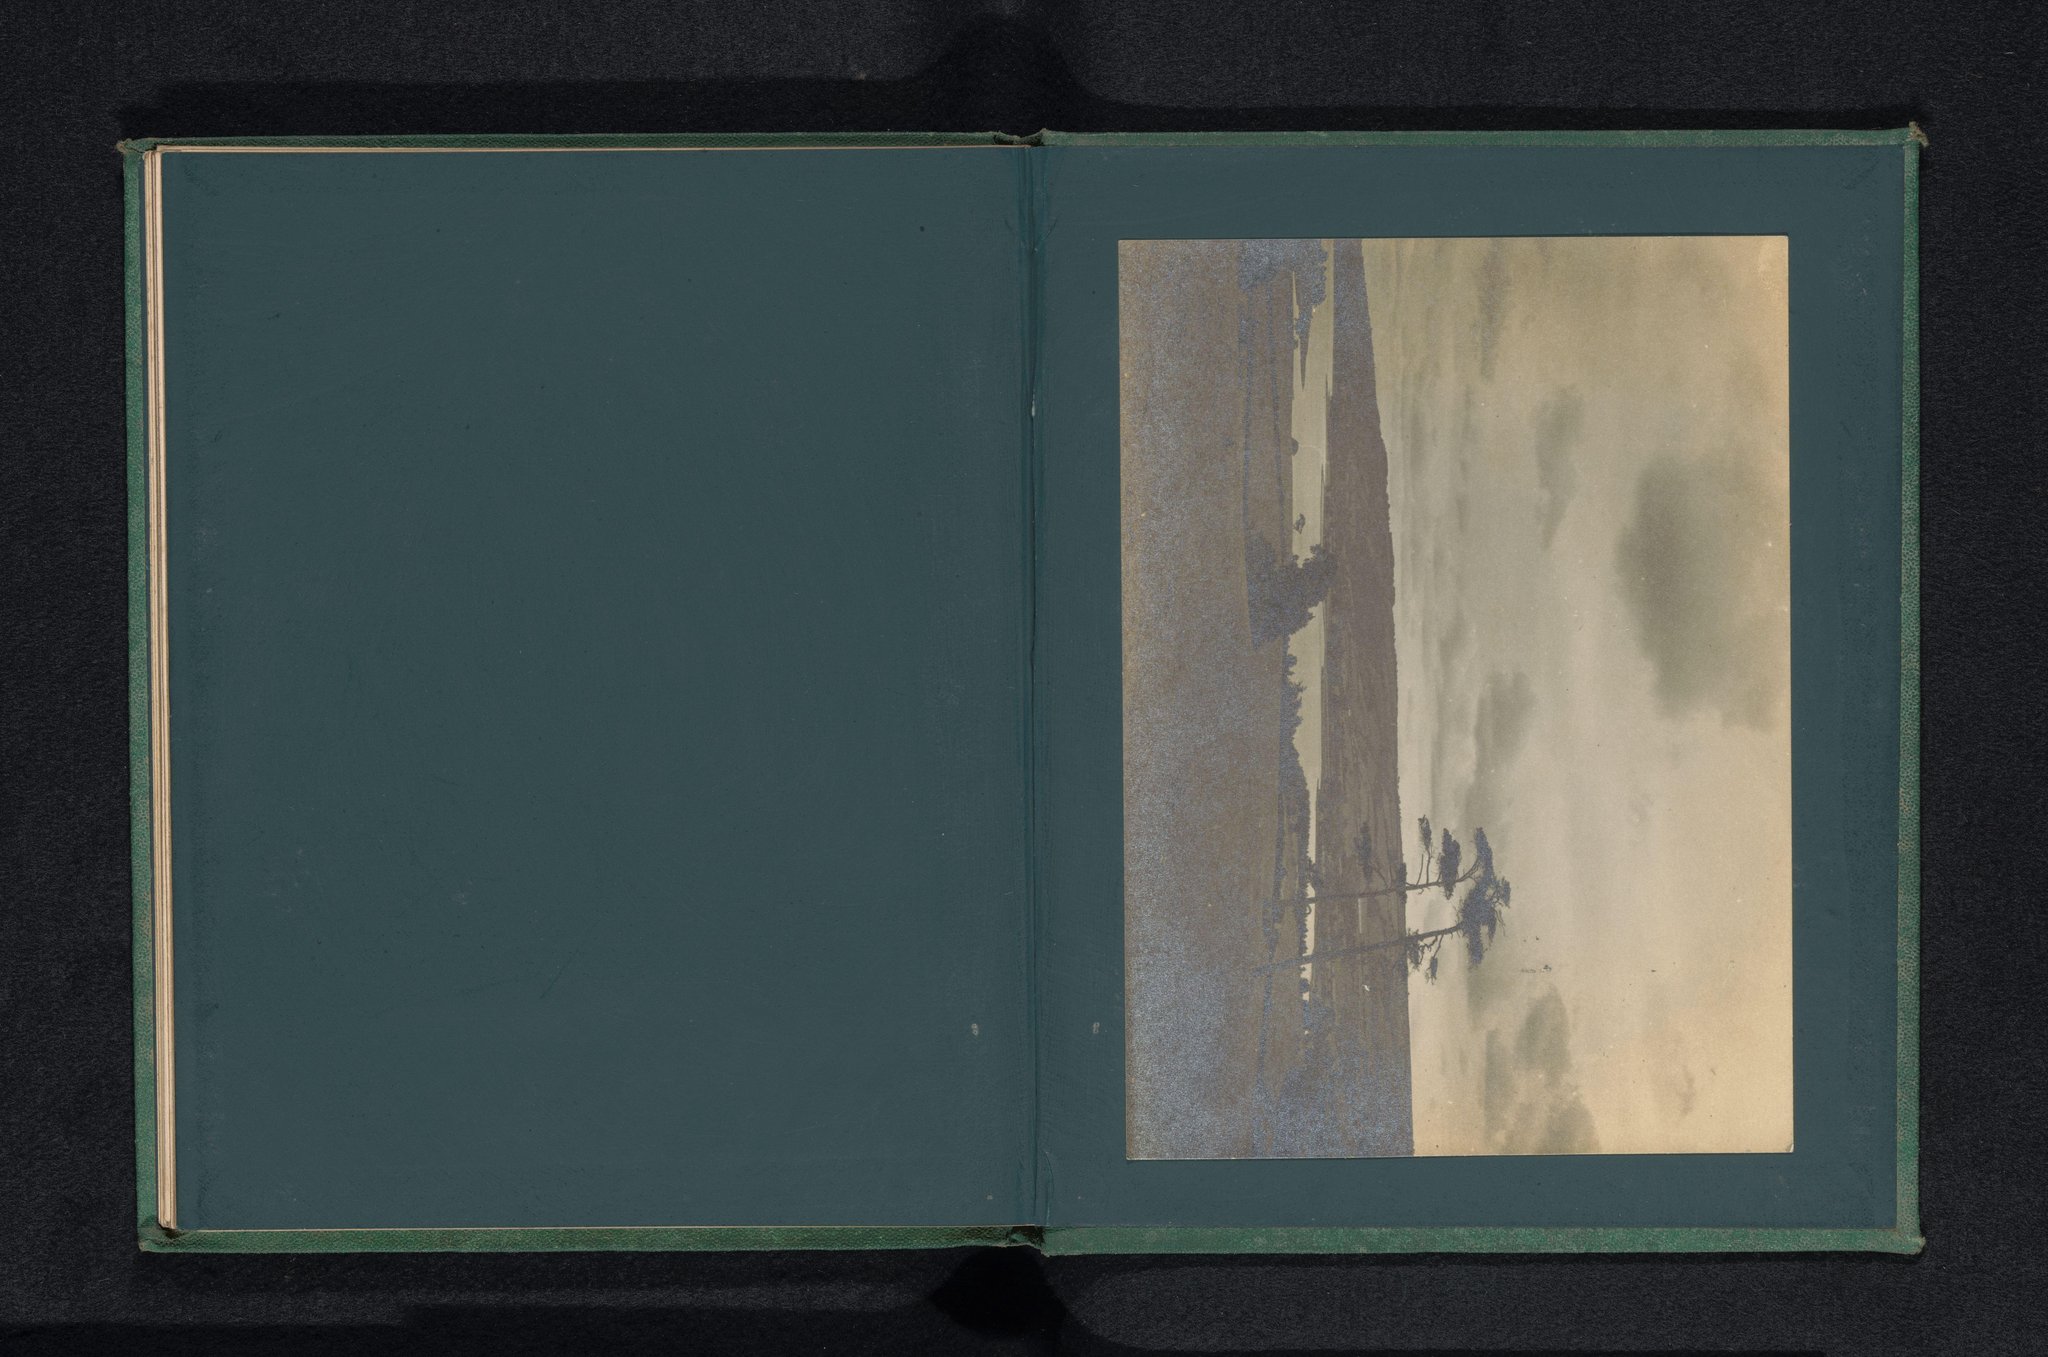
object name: page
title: Gezicht op een rivier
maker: Anonymous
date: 1880-1920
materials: photographic support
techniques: gelatin silver print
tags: river, landscapes with waters, waterscapes, seascapes (in the temperate zone)